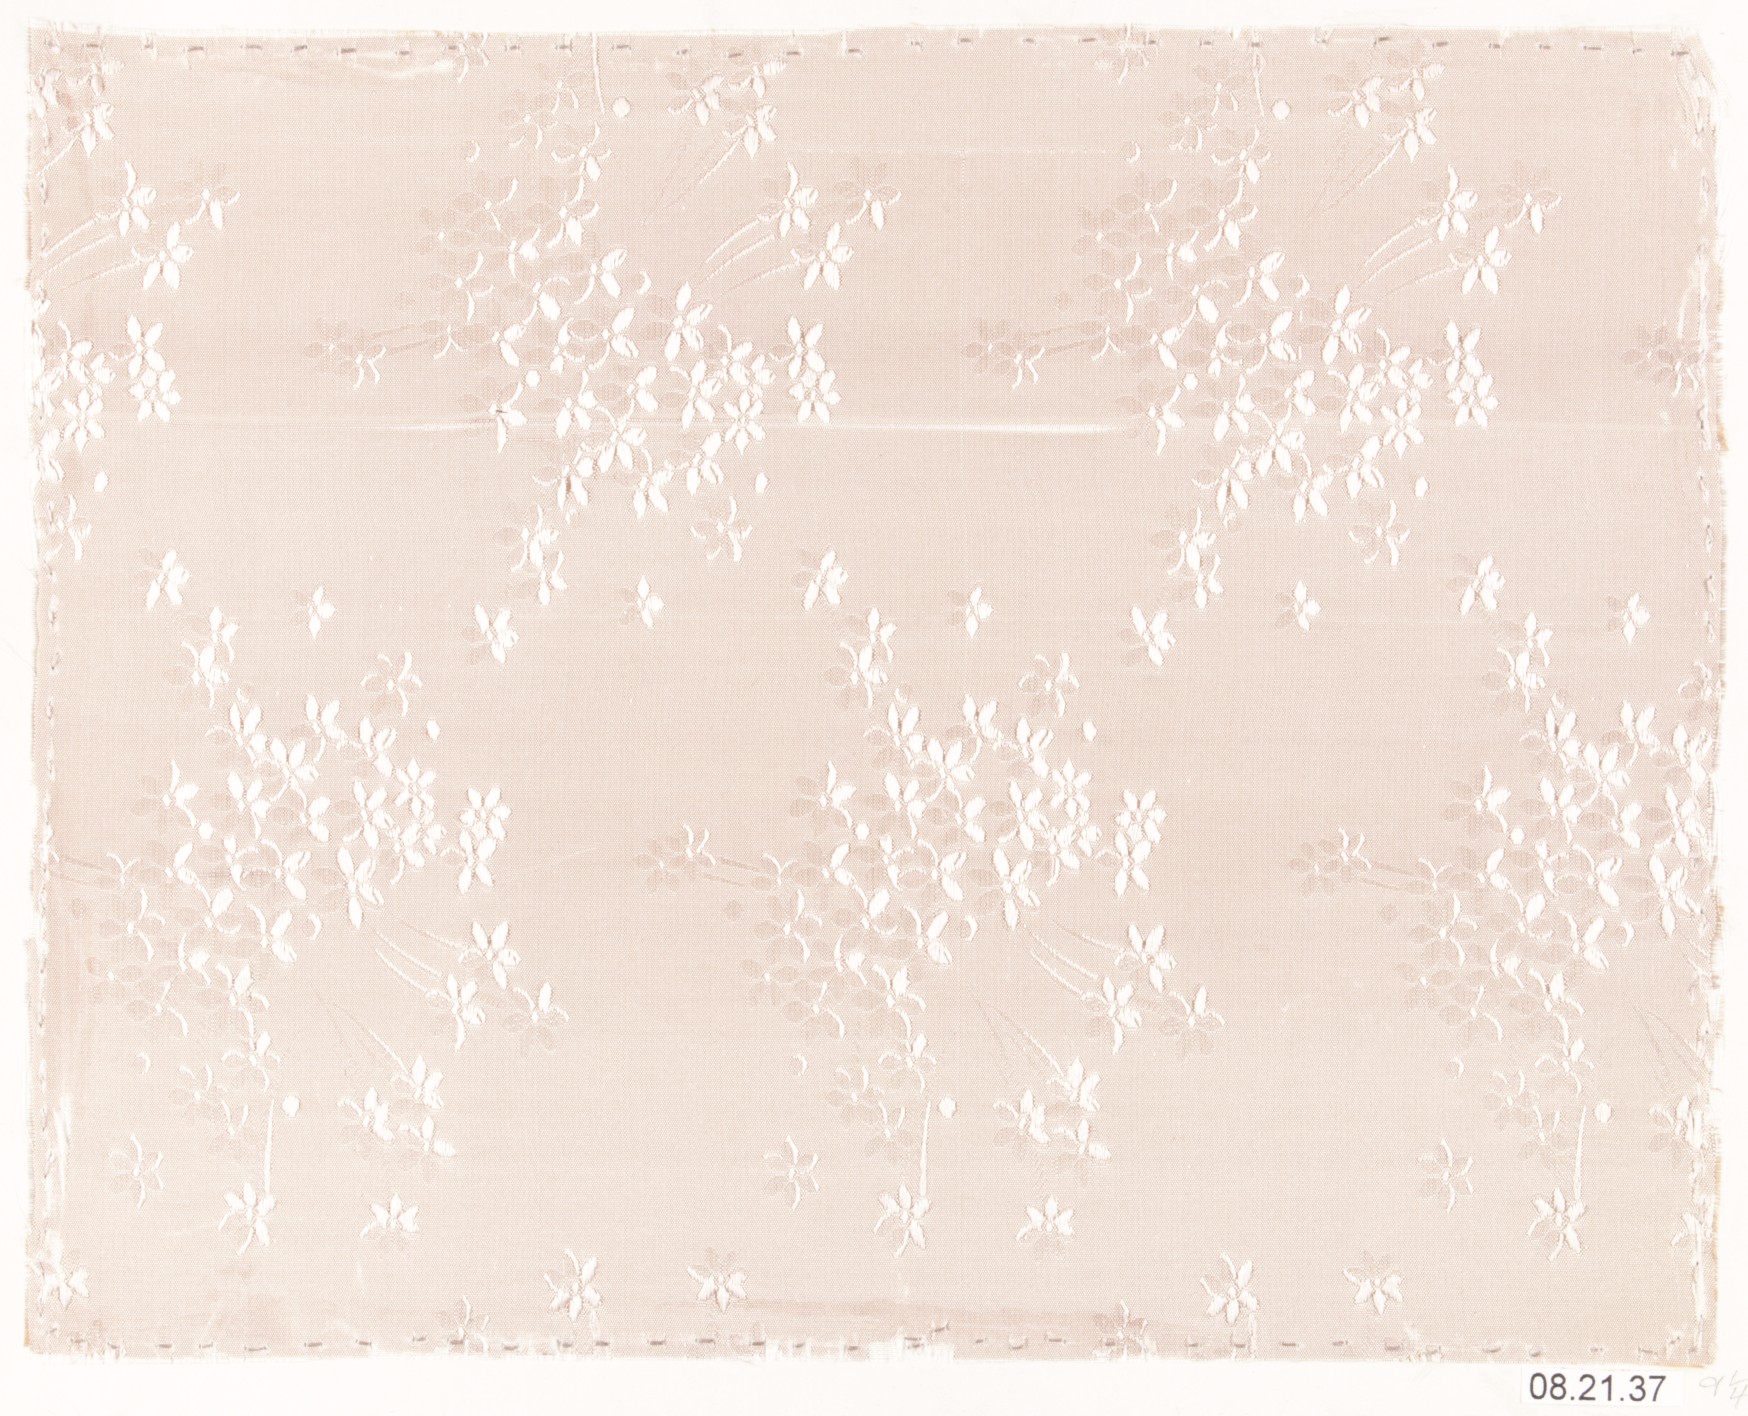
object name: textile sample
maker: Anonymous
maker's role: designer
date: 1900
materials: silk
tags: flowers